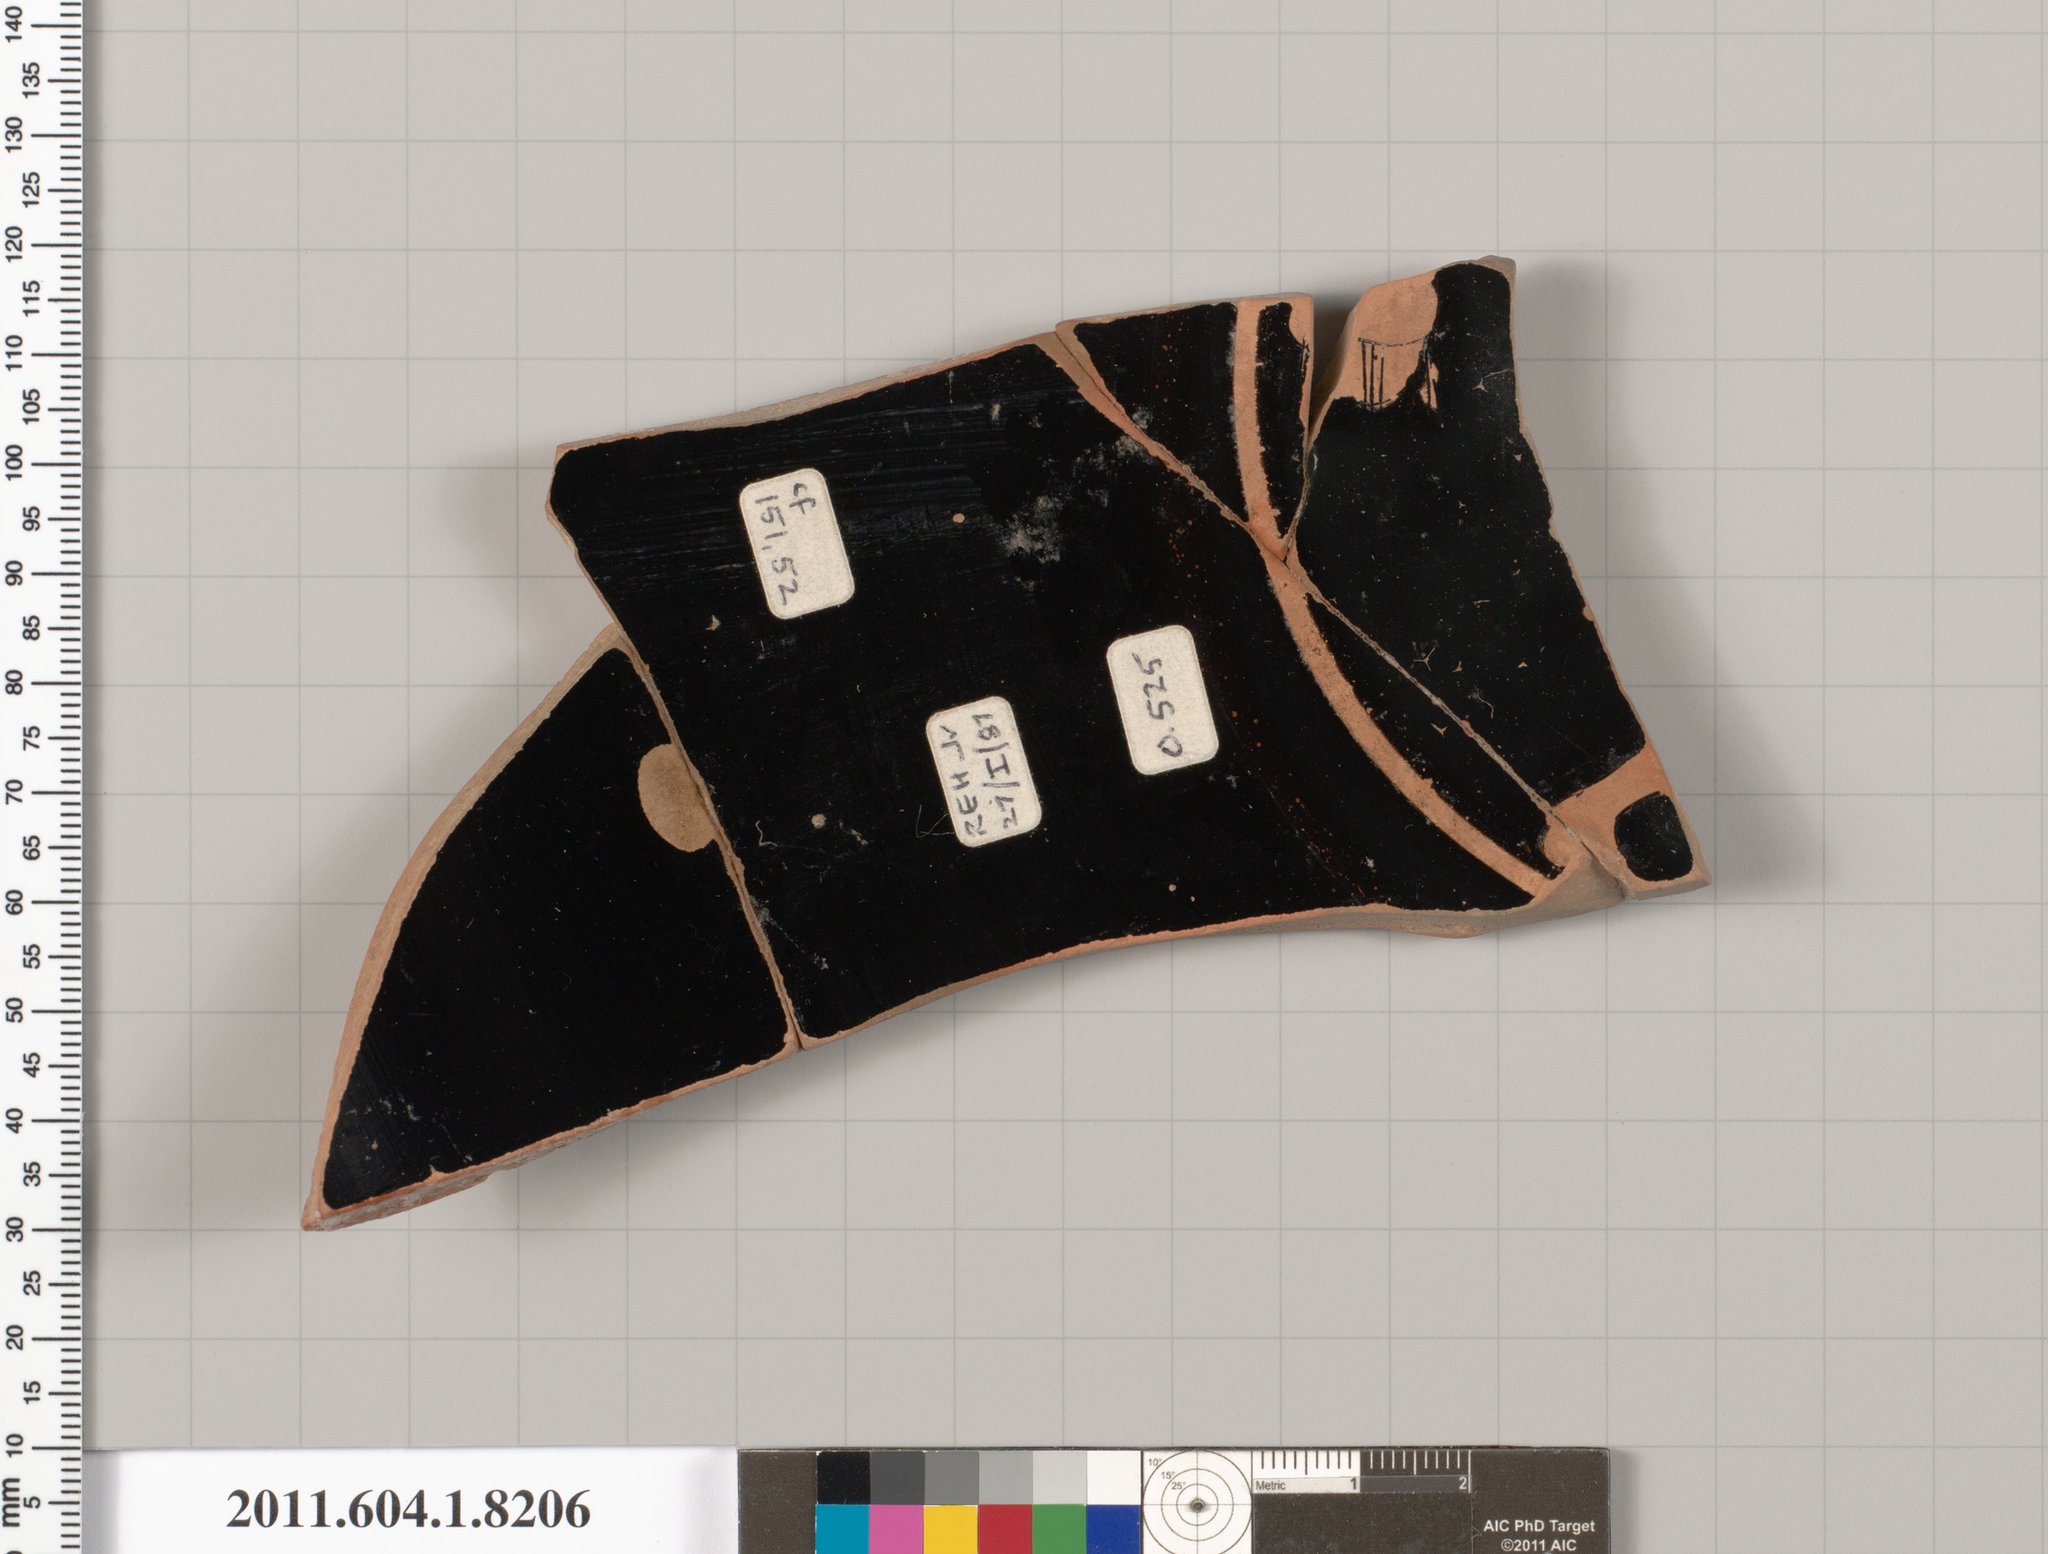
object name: kylix fragment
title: Terracotta fragment of a kylix (drinking cup)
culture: greek, attic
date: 520-510 BCE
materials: terracotta